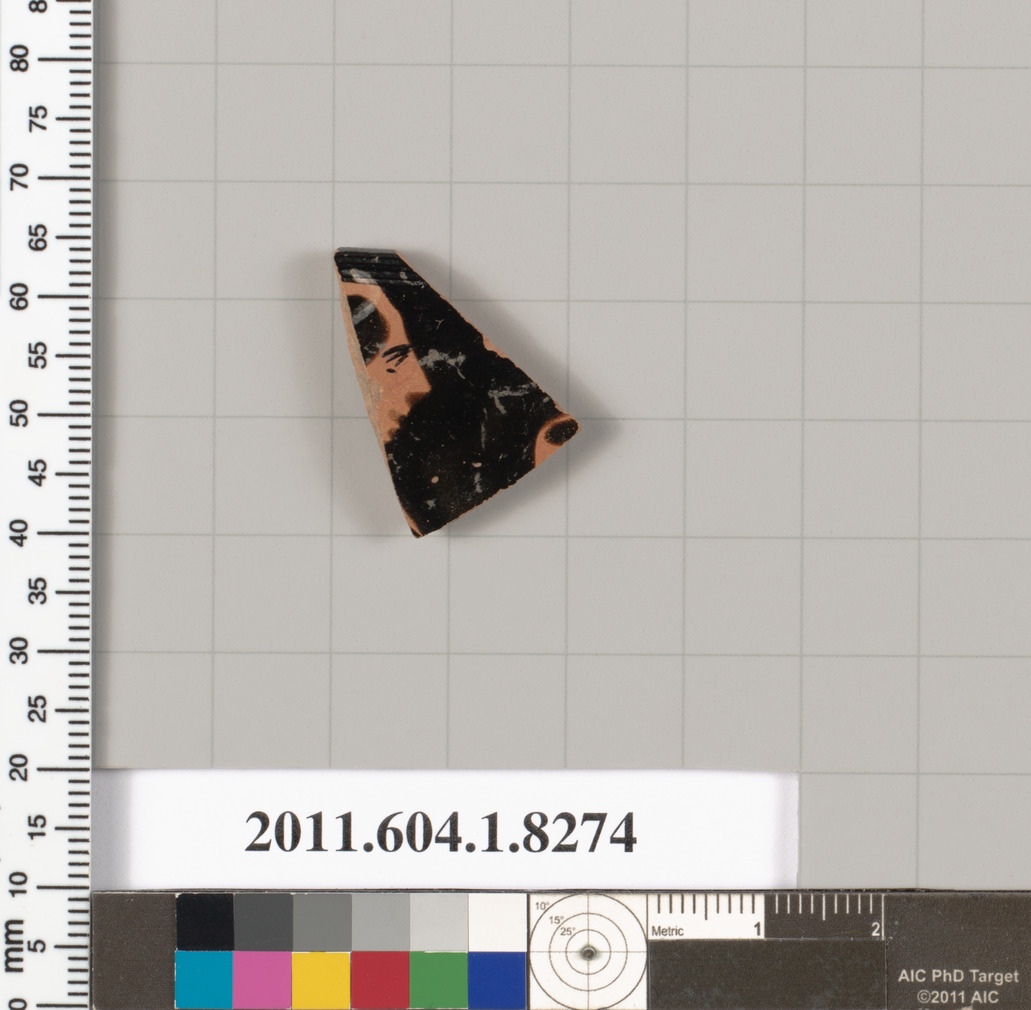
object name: kylix fragment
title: Terracotta rim fragment of a kylix (drinking cup)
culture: greek, attic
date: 400-351 BCE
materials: terracotta